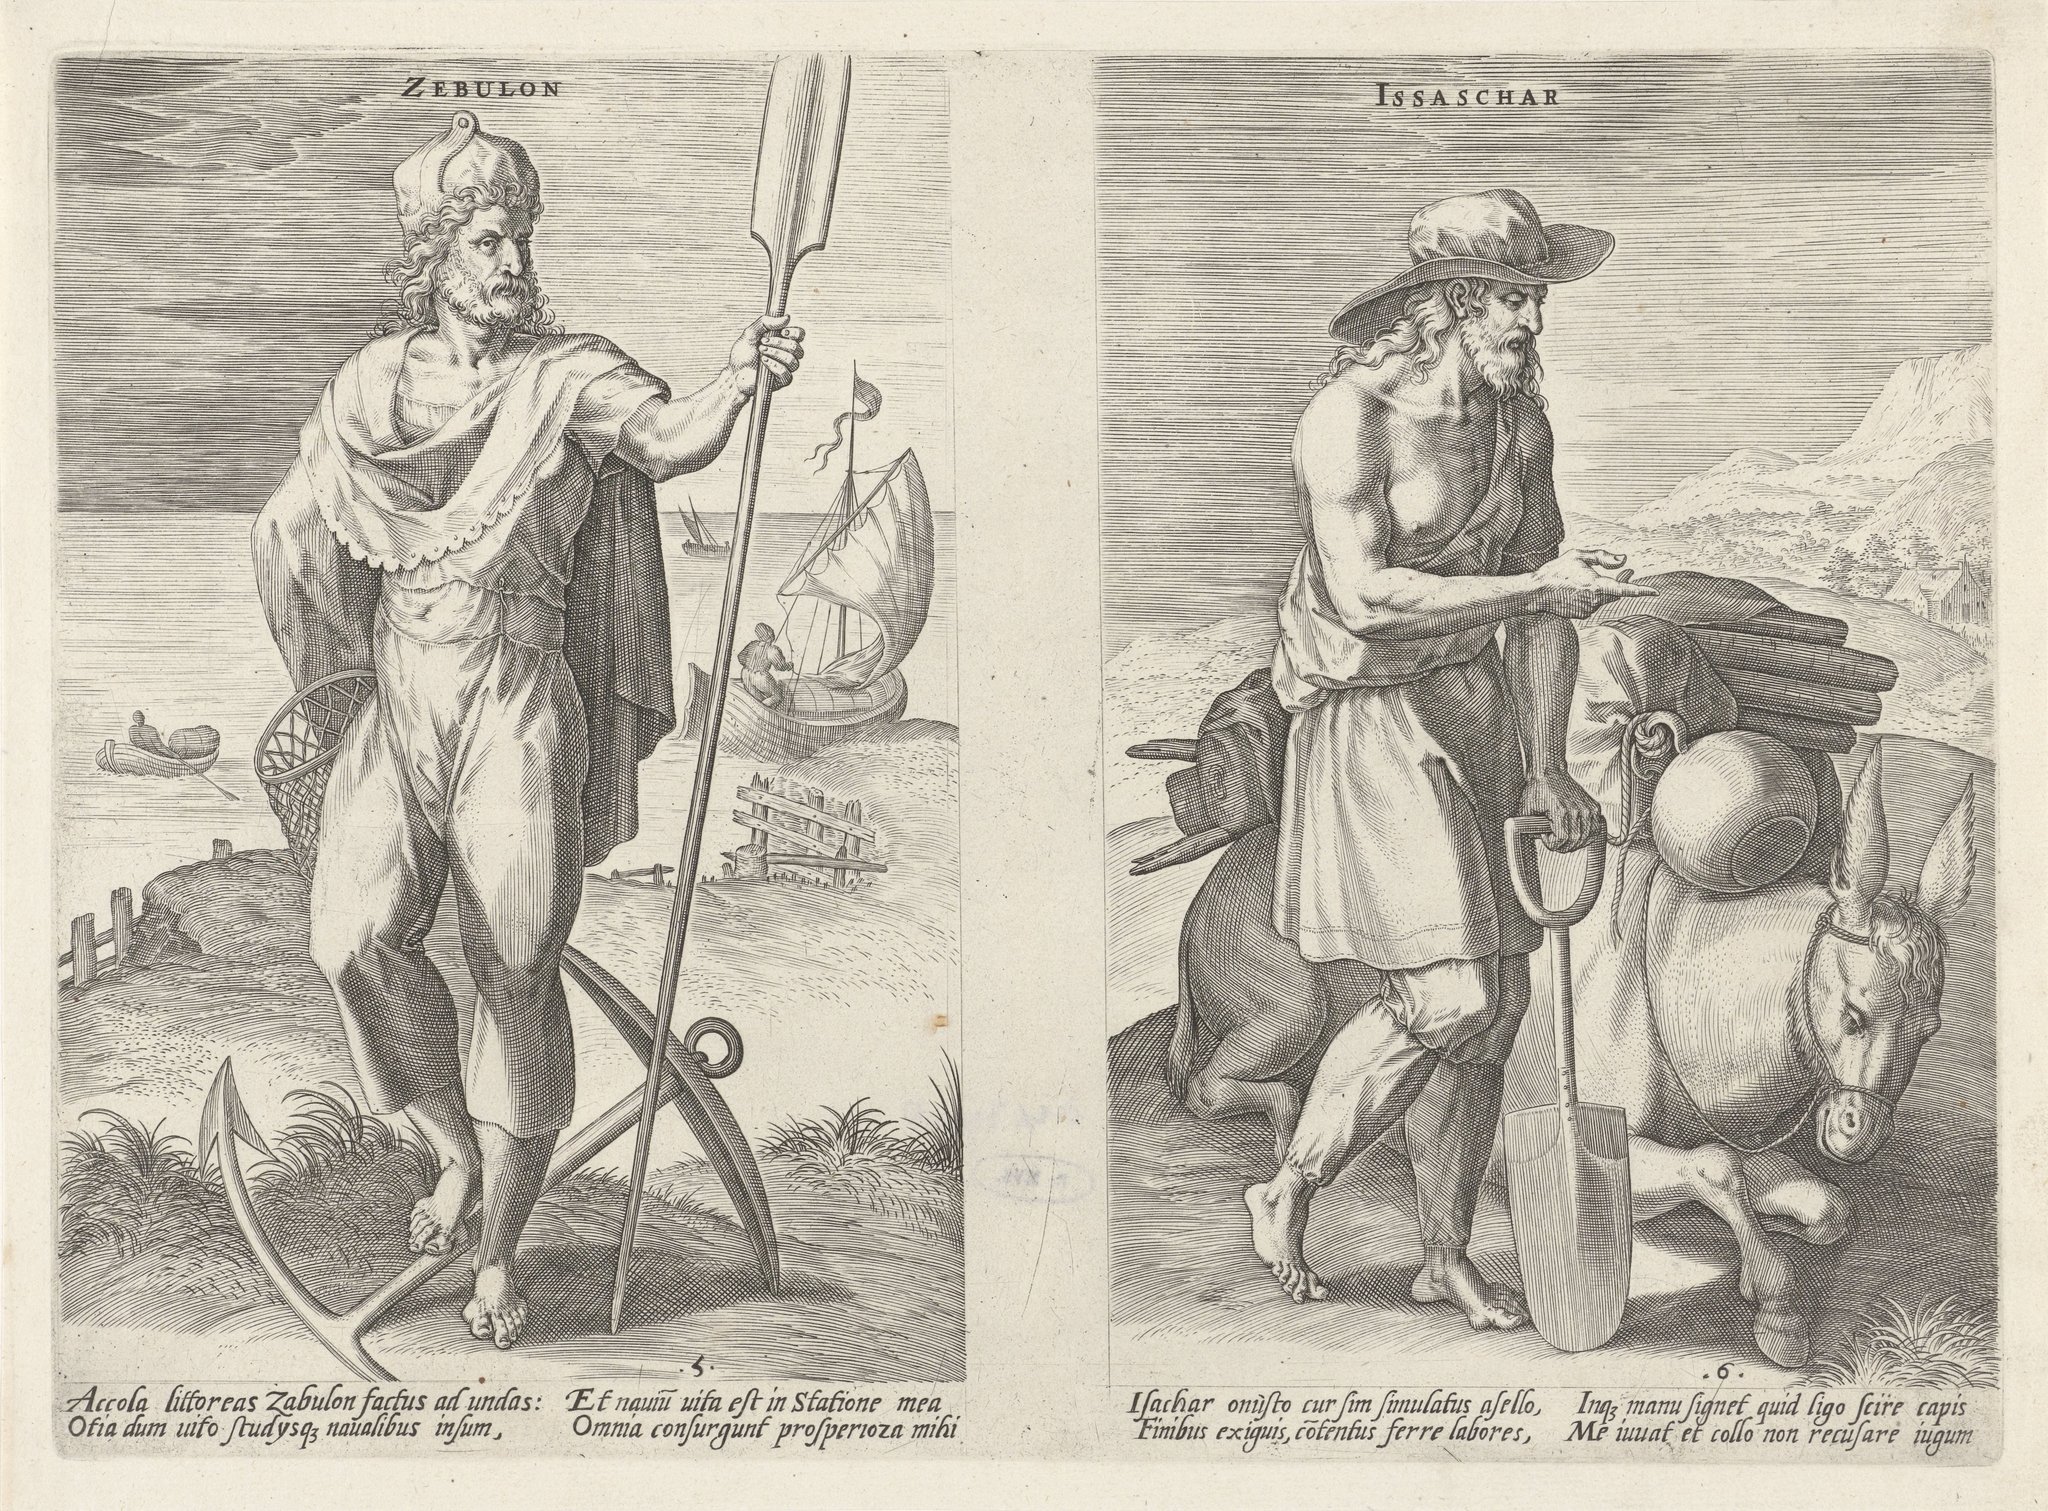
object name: print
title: Stamvaders Zebulon en Issachar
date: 1579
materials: paper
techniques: engraving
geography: amsterdam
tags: 11i611(issaschar), 11i611(zebulon)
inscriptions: collector's mark: Lugt 2228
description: Links de stamvader Zebulon, de tiende zoon van Jakob. Hij is gekleed als visser. Op de grond naast hem een anker. Op de achtergrond de zee en een strand, een verwijzing naar de woonplaats van Zebulon. Rechts de stamvader Issachar, de negende zoon van Jakob. Naast hem ligt een ezel, een verwijzingen naar Issachar als een 'sterke ezel' die 'zijn last droeg'. Elke afbeelding heeft een Latijns onderschrift en het blad bevat de vijfde en zesde prent uit een serie met als onderwerp de twaalf stamvaders van Israël.